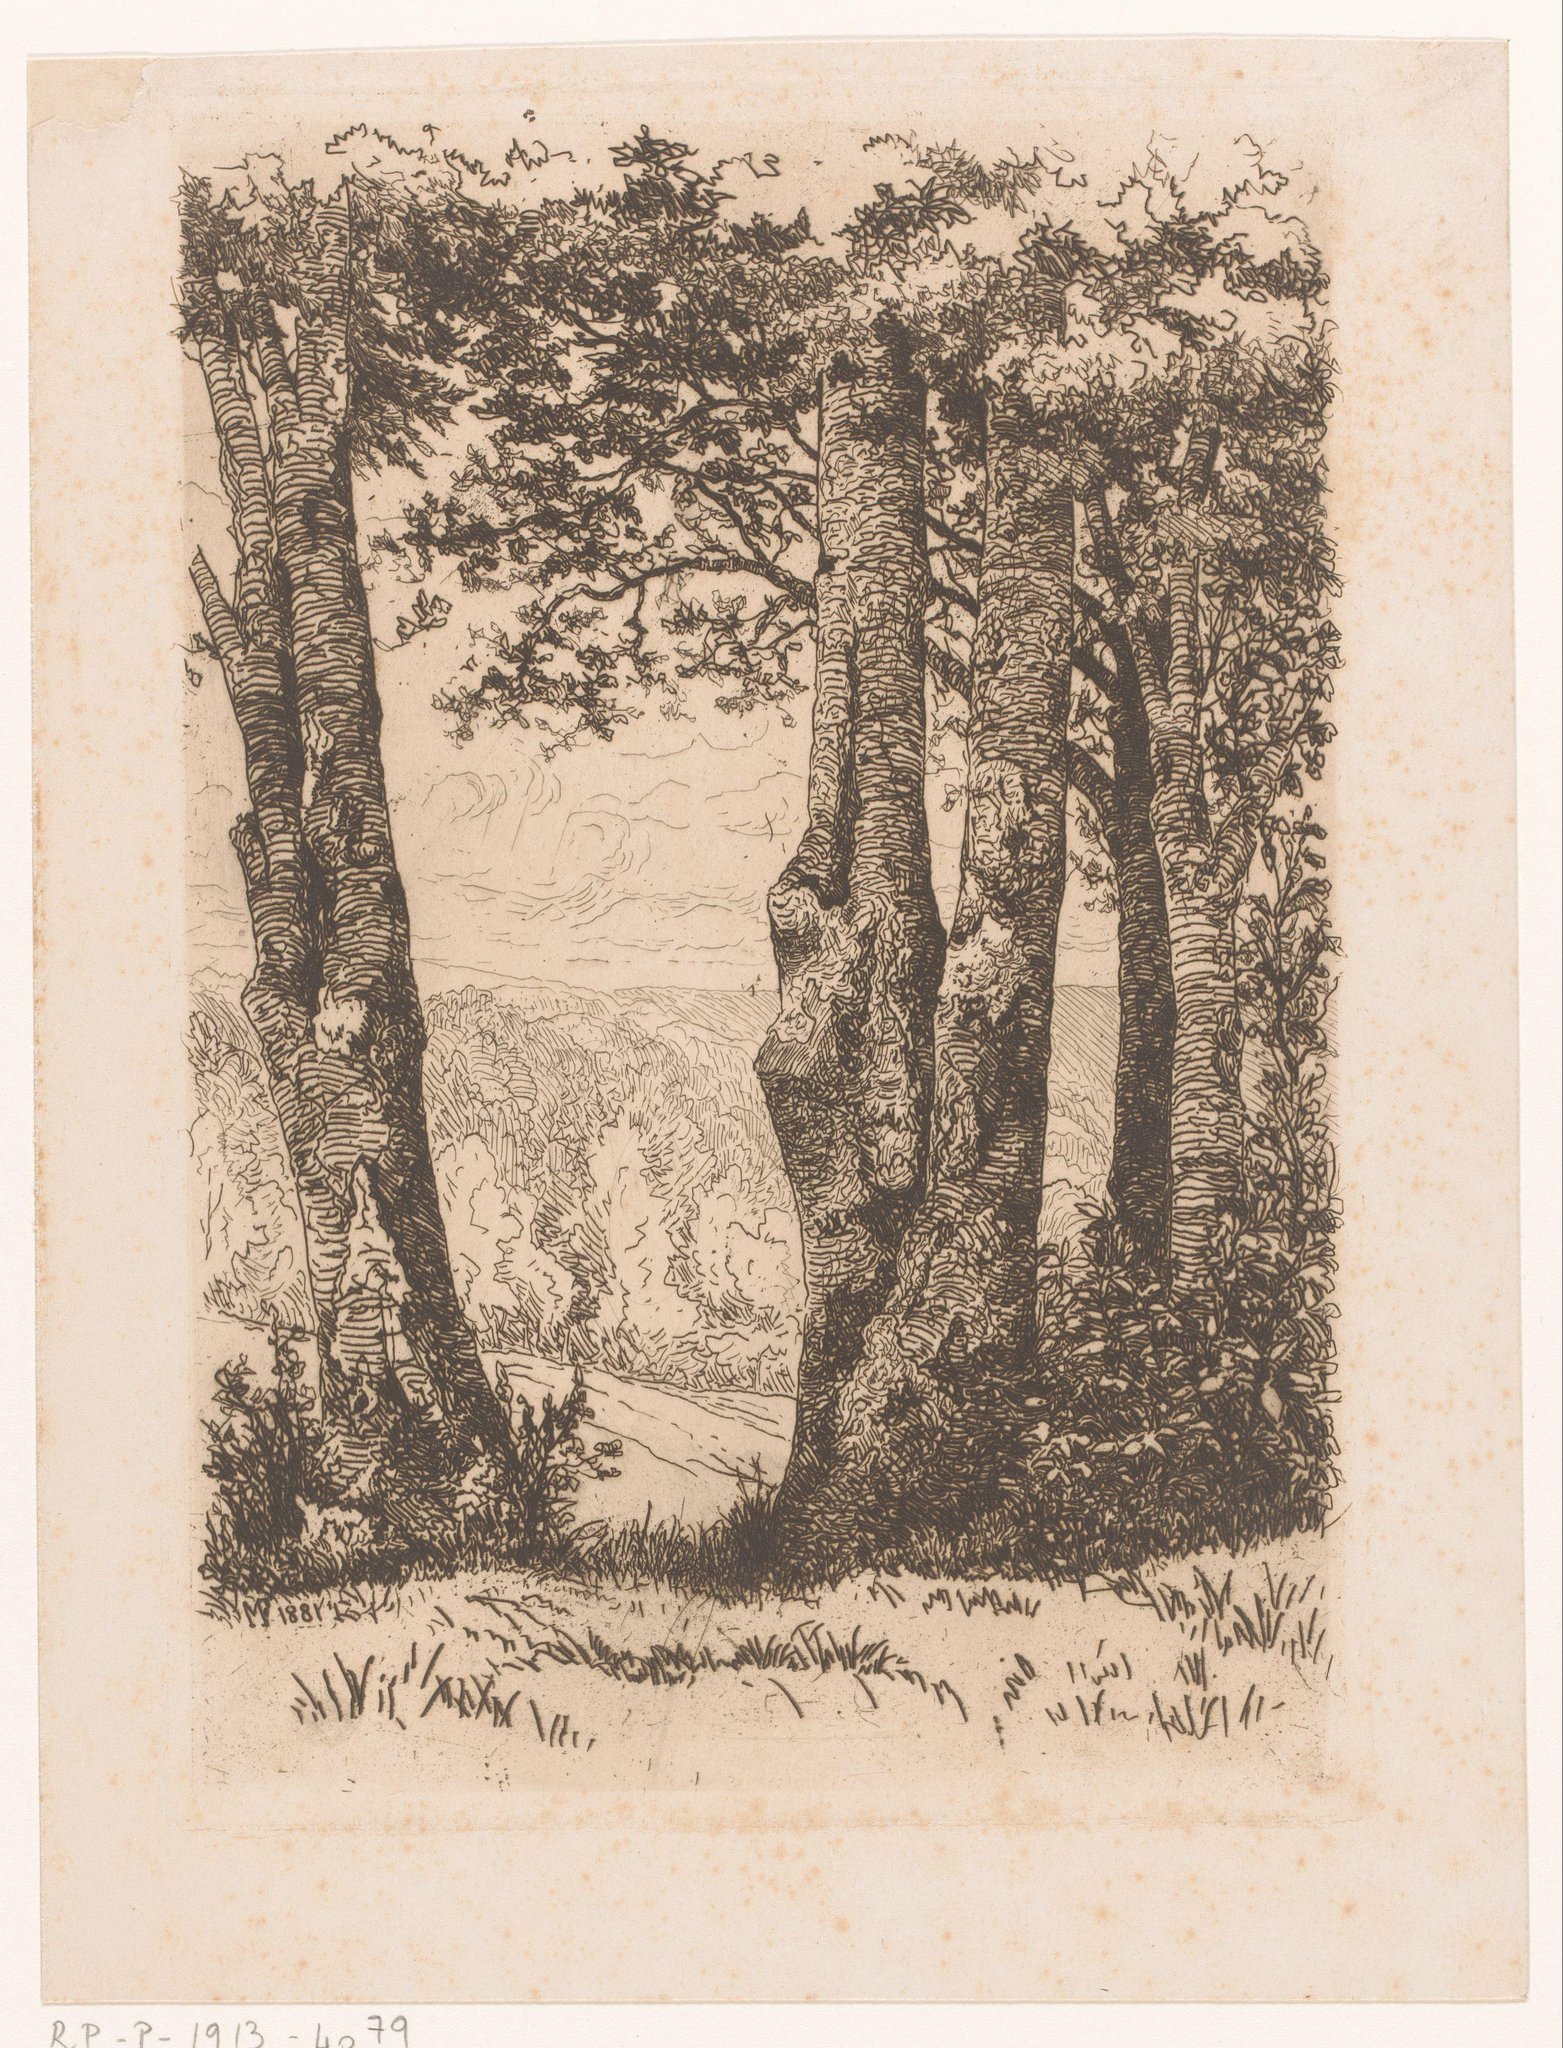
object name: print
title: Landschap met bomenrij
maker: maria van hohenzollern-sigmaringen (gravin van vlaanderen)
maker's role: print maker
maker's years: 1845-1912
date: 1881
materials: paper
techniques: etching, retroussage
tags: trees, landscapes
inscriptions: collector's mark: Lugt 2228